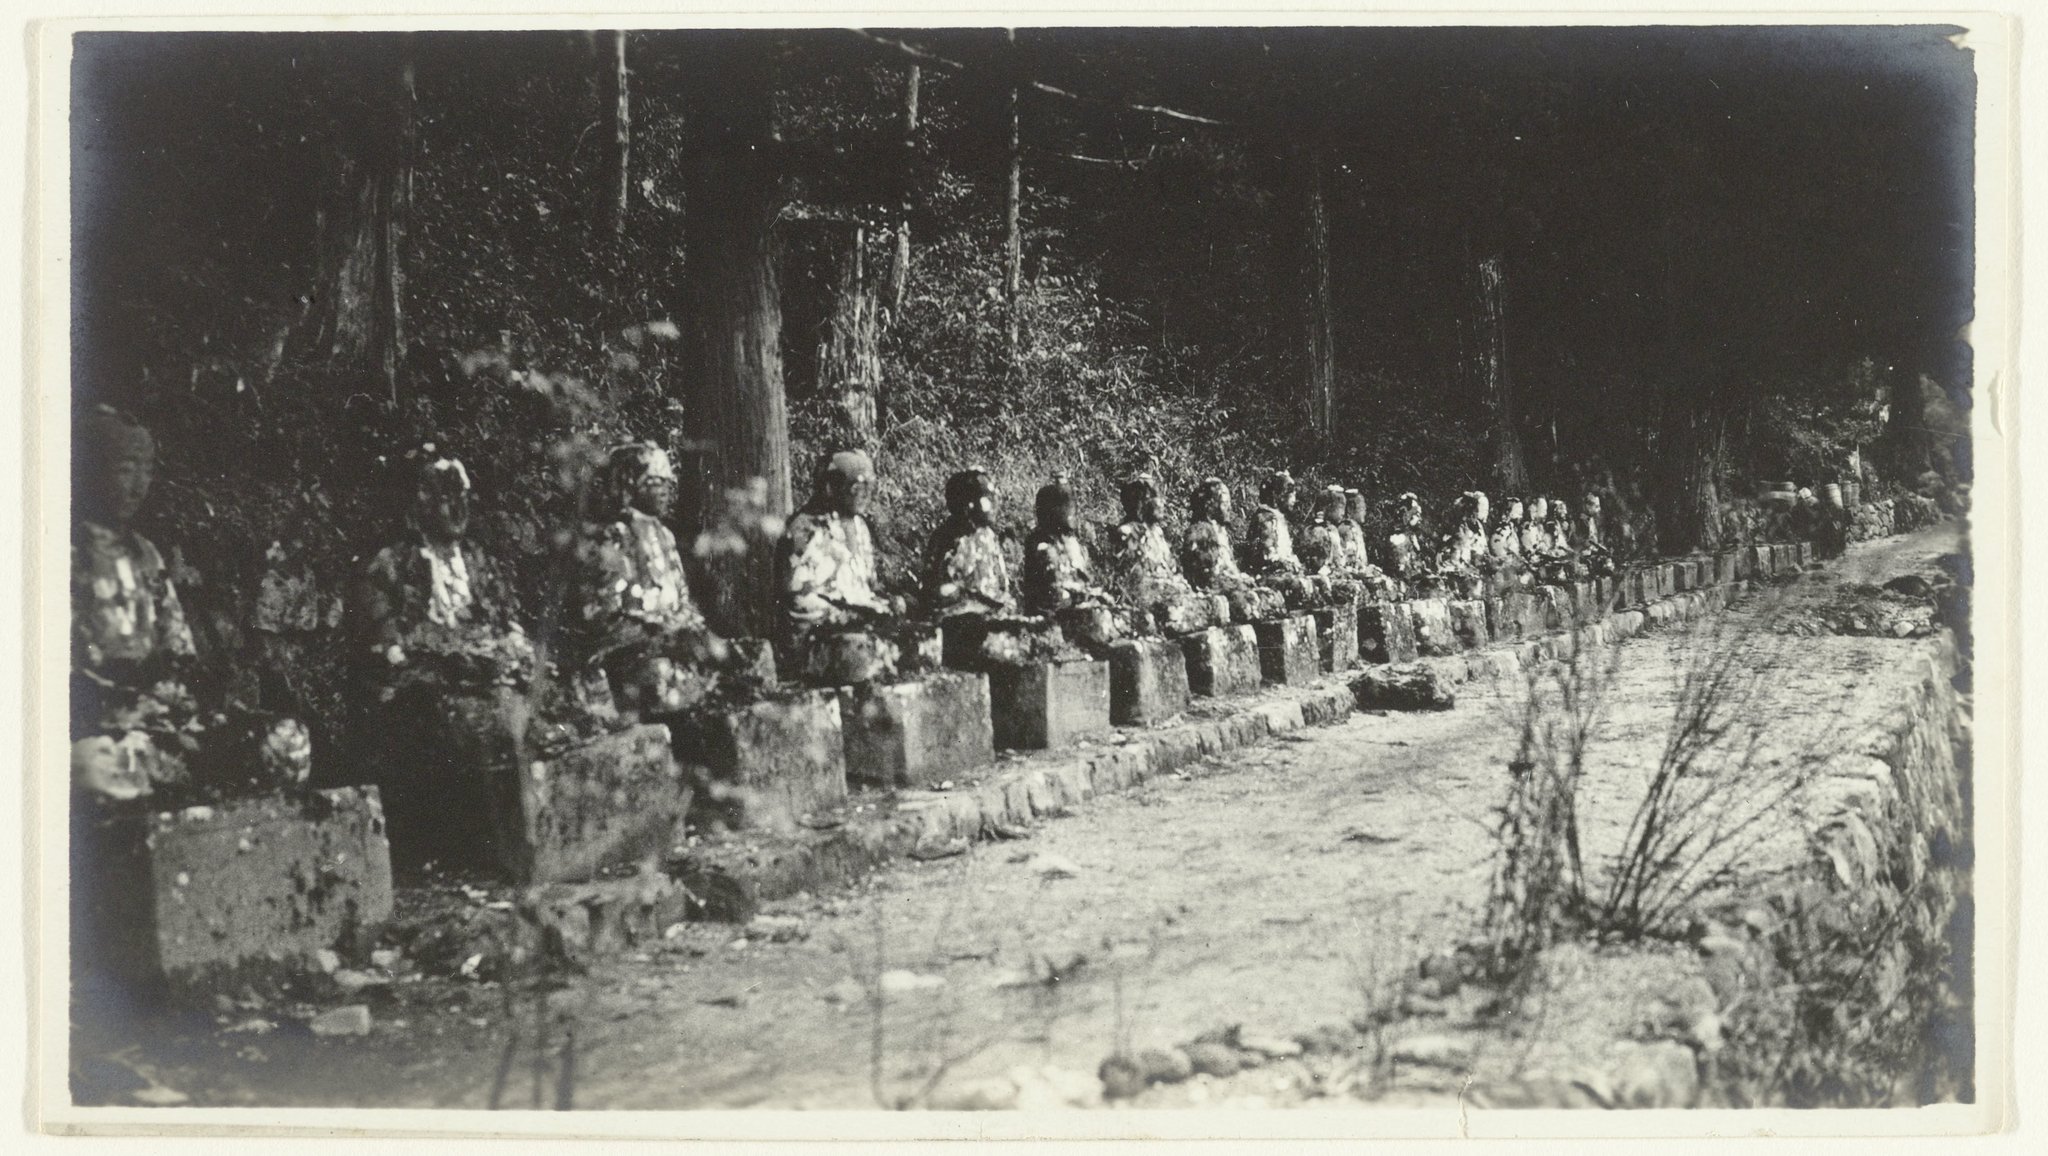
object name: photograph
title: Een rij beelden (boeddha?), Toshogu heiligdom, Nikko, Japan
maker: jan adriani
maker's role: fotograaf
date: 1907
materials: paper, photographic support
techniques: gelatin silver print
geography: japan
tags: gallery of sculptures